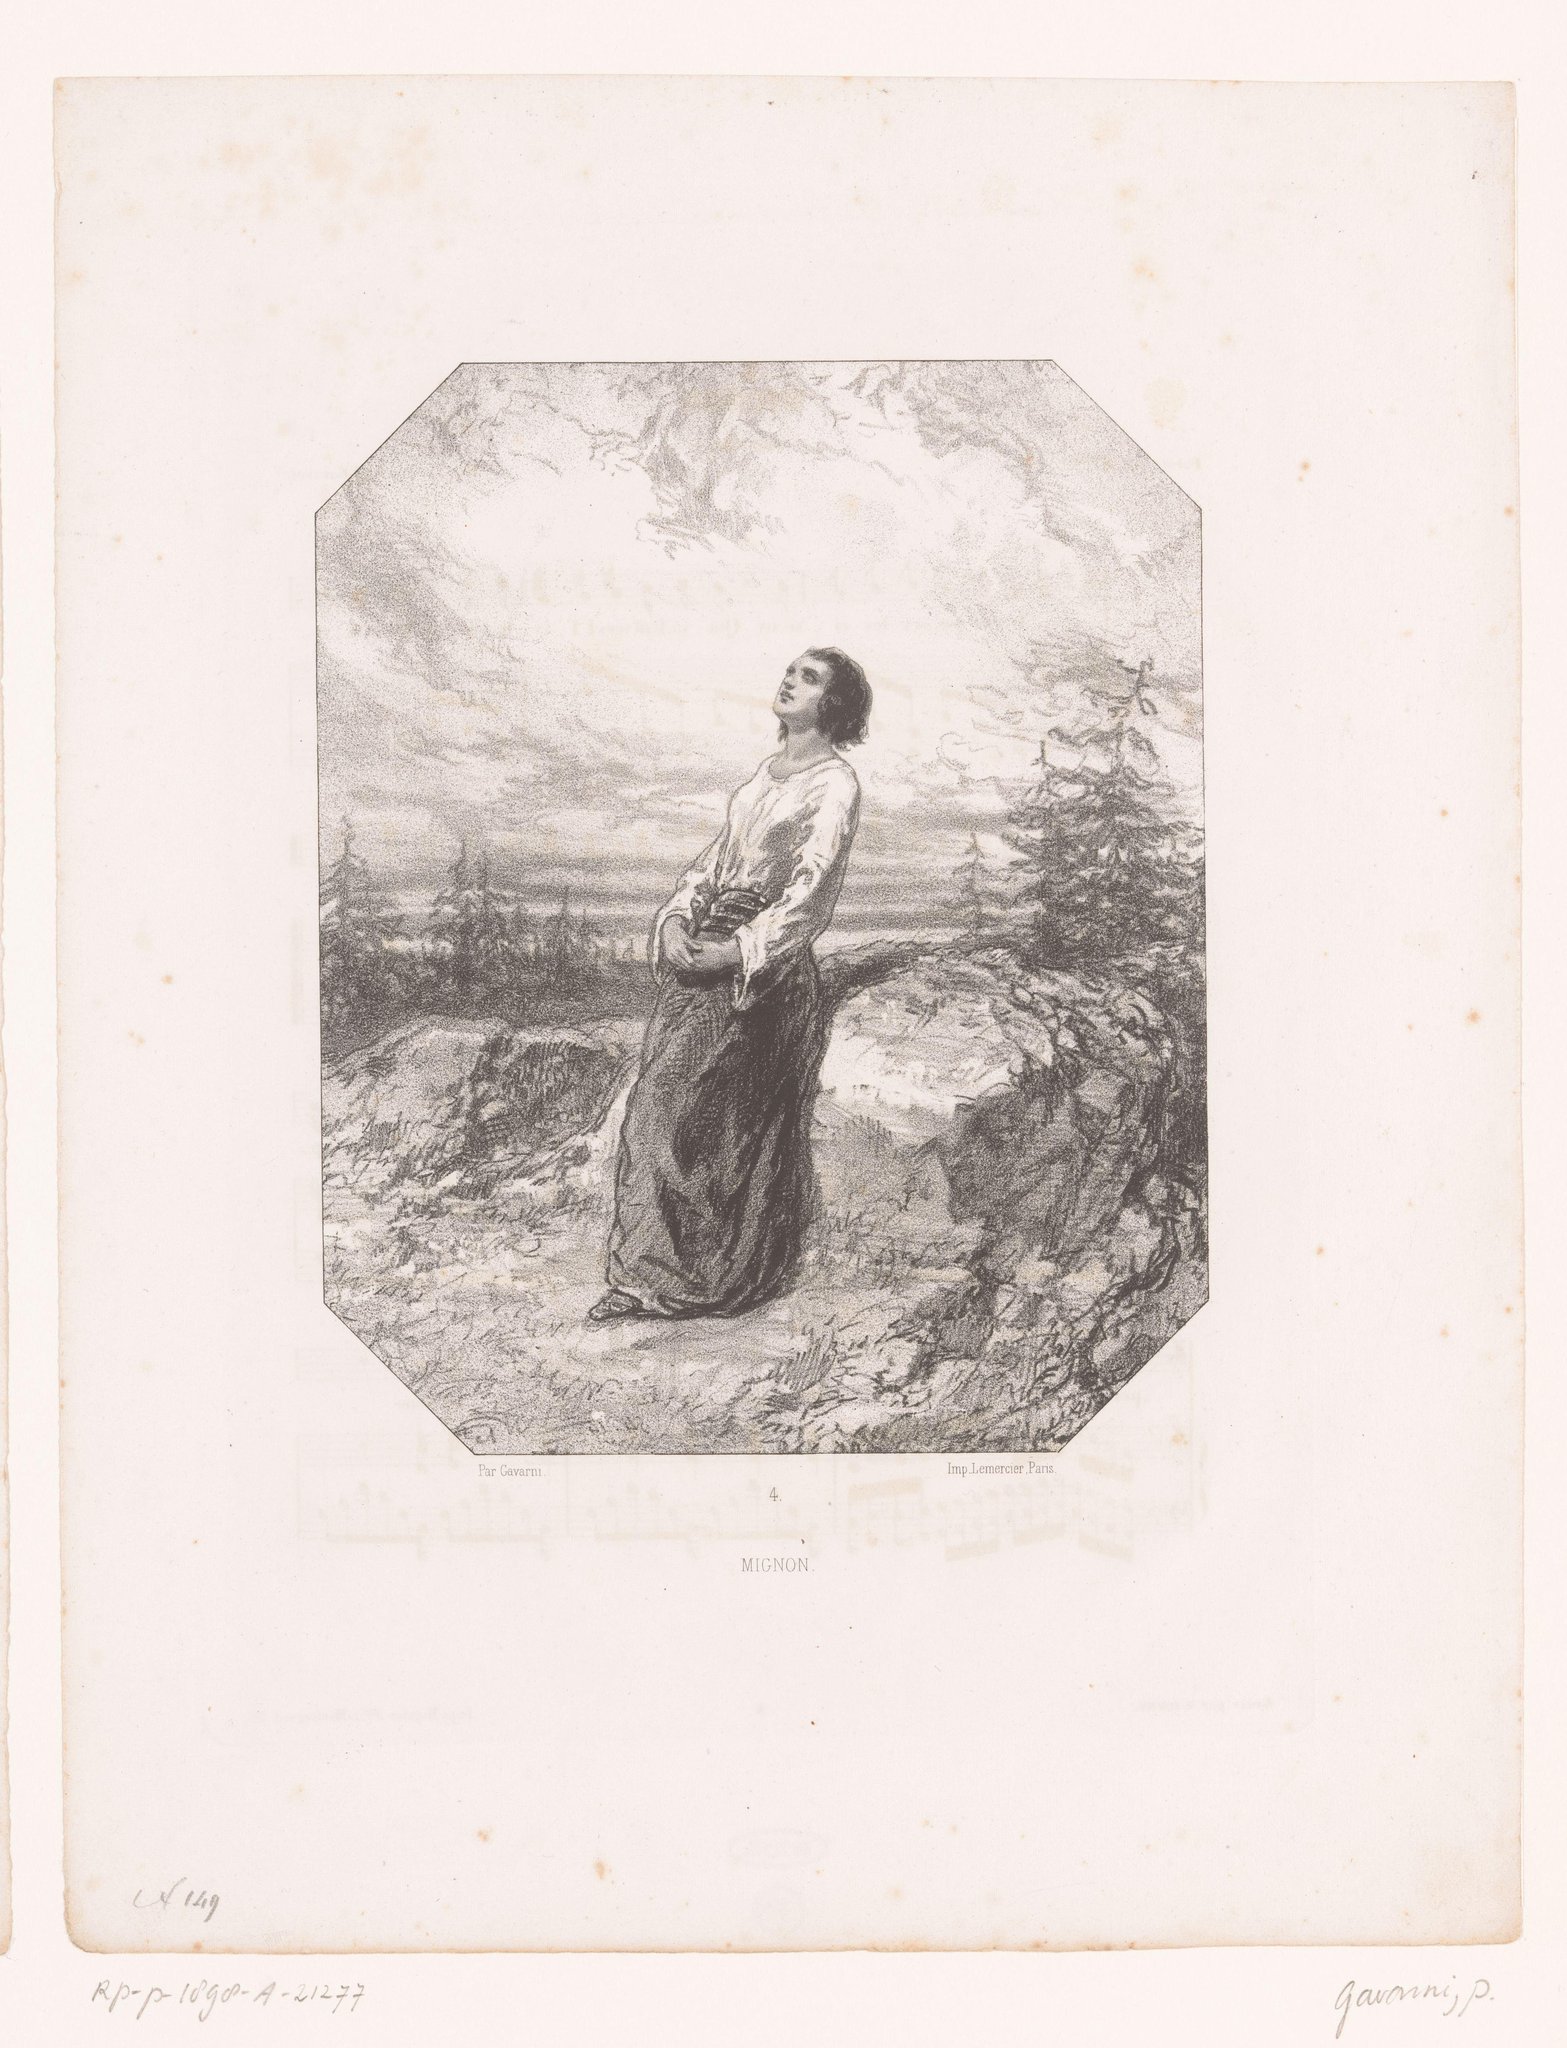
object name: print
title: Illustraties bij de liederen van Jeanne Gavarni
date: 1854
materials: paper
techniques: lithograph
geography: paris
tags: contemplating the firmament, adolescent, young woman, maiden, clouds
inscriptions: collector's mark: Lugt 964